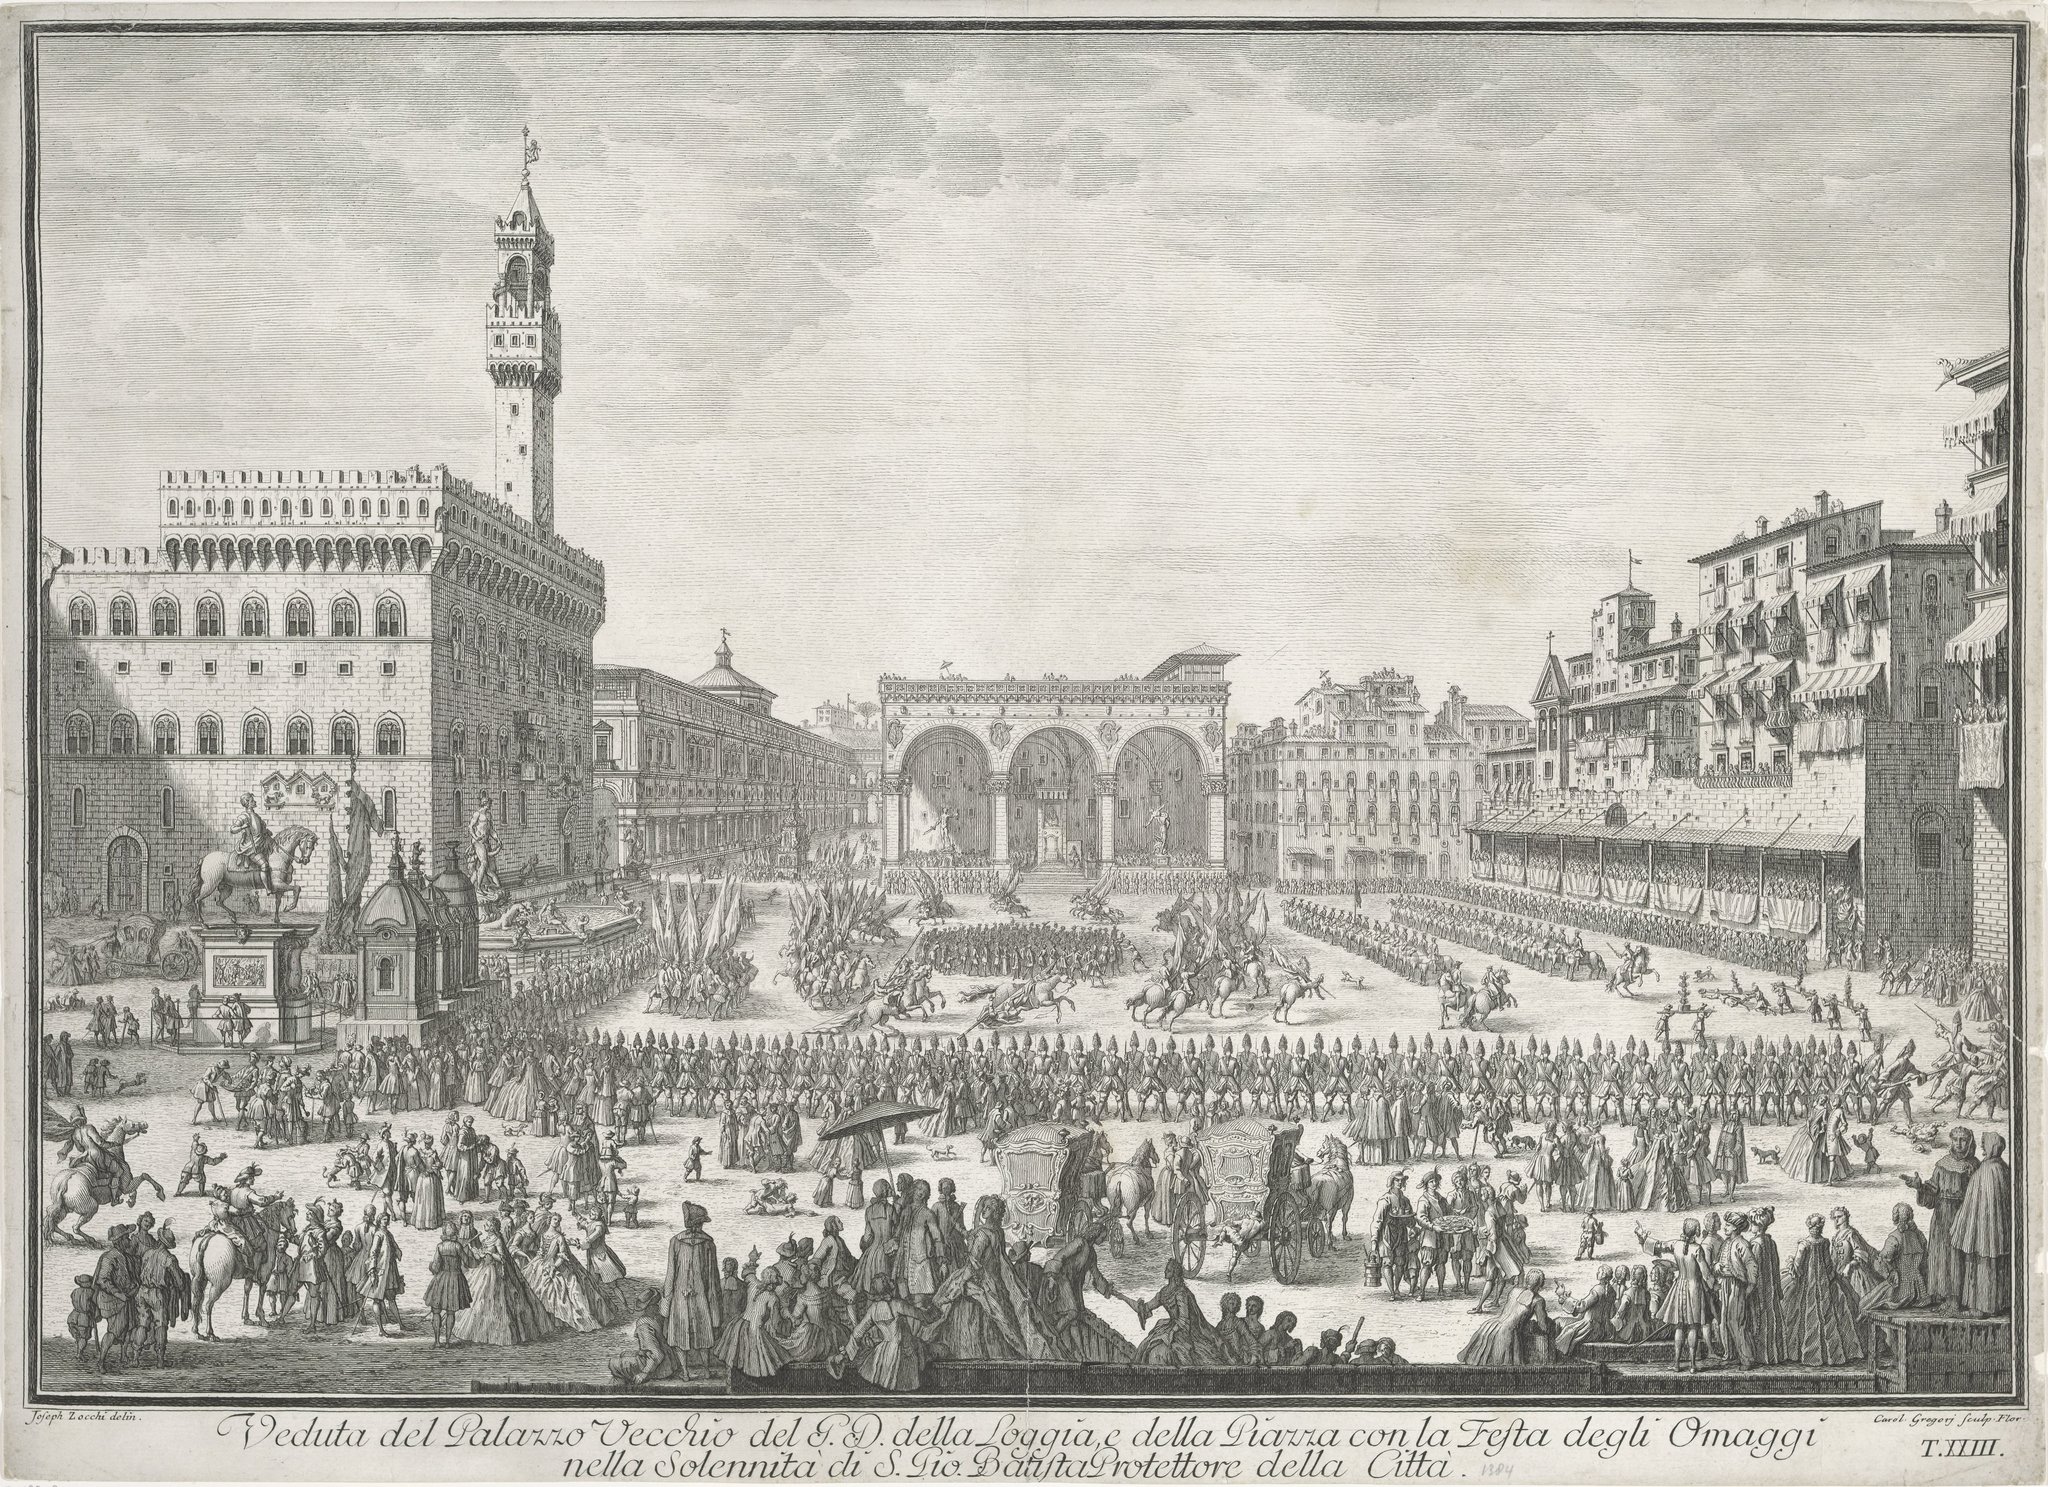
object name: print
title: Festiviteiten op het Piazza della Signoria te Florence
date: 1729-1759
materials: paper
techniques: etching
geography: florence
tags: square, place, circus, etc., festivities (+ the public ~ festive activities)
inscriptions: collector's mark: Lugt 2228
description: Gezicht op het Piazza della Signoria te Florence met het Palazzo Vecchio, de Galleria degli Uffizi en de Loggia dei Lanzi. Op het plein vinden festiviteiten plaats, een parade met ruiters te paard, ter ere van de heilige Johannes de Doper, de beschermheilige van de stad. Genummerd rechtsonder: T. XXIII.